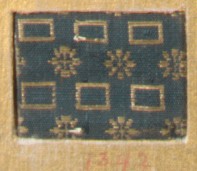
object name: piece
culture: japanese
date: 1701-1900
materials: silk